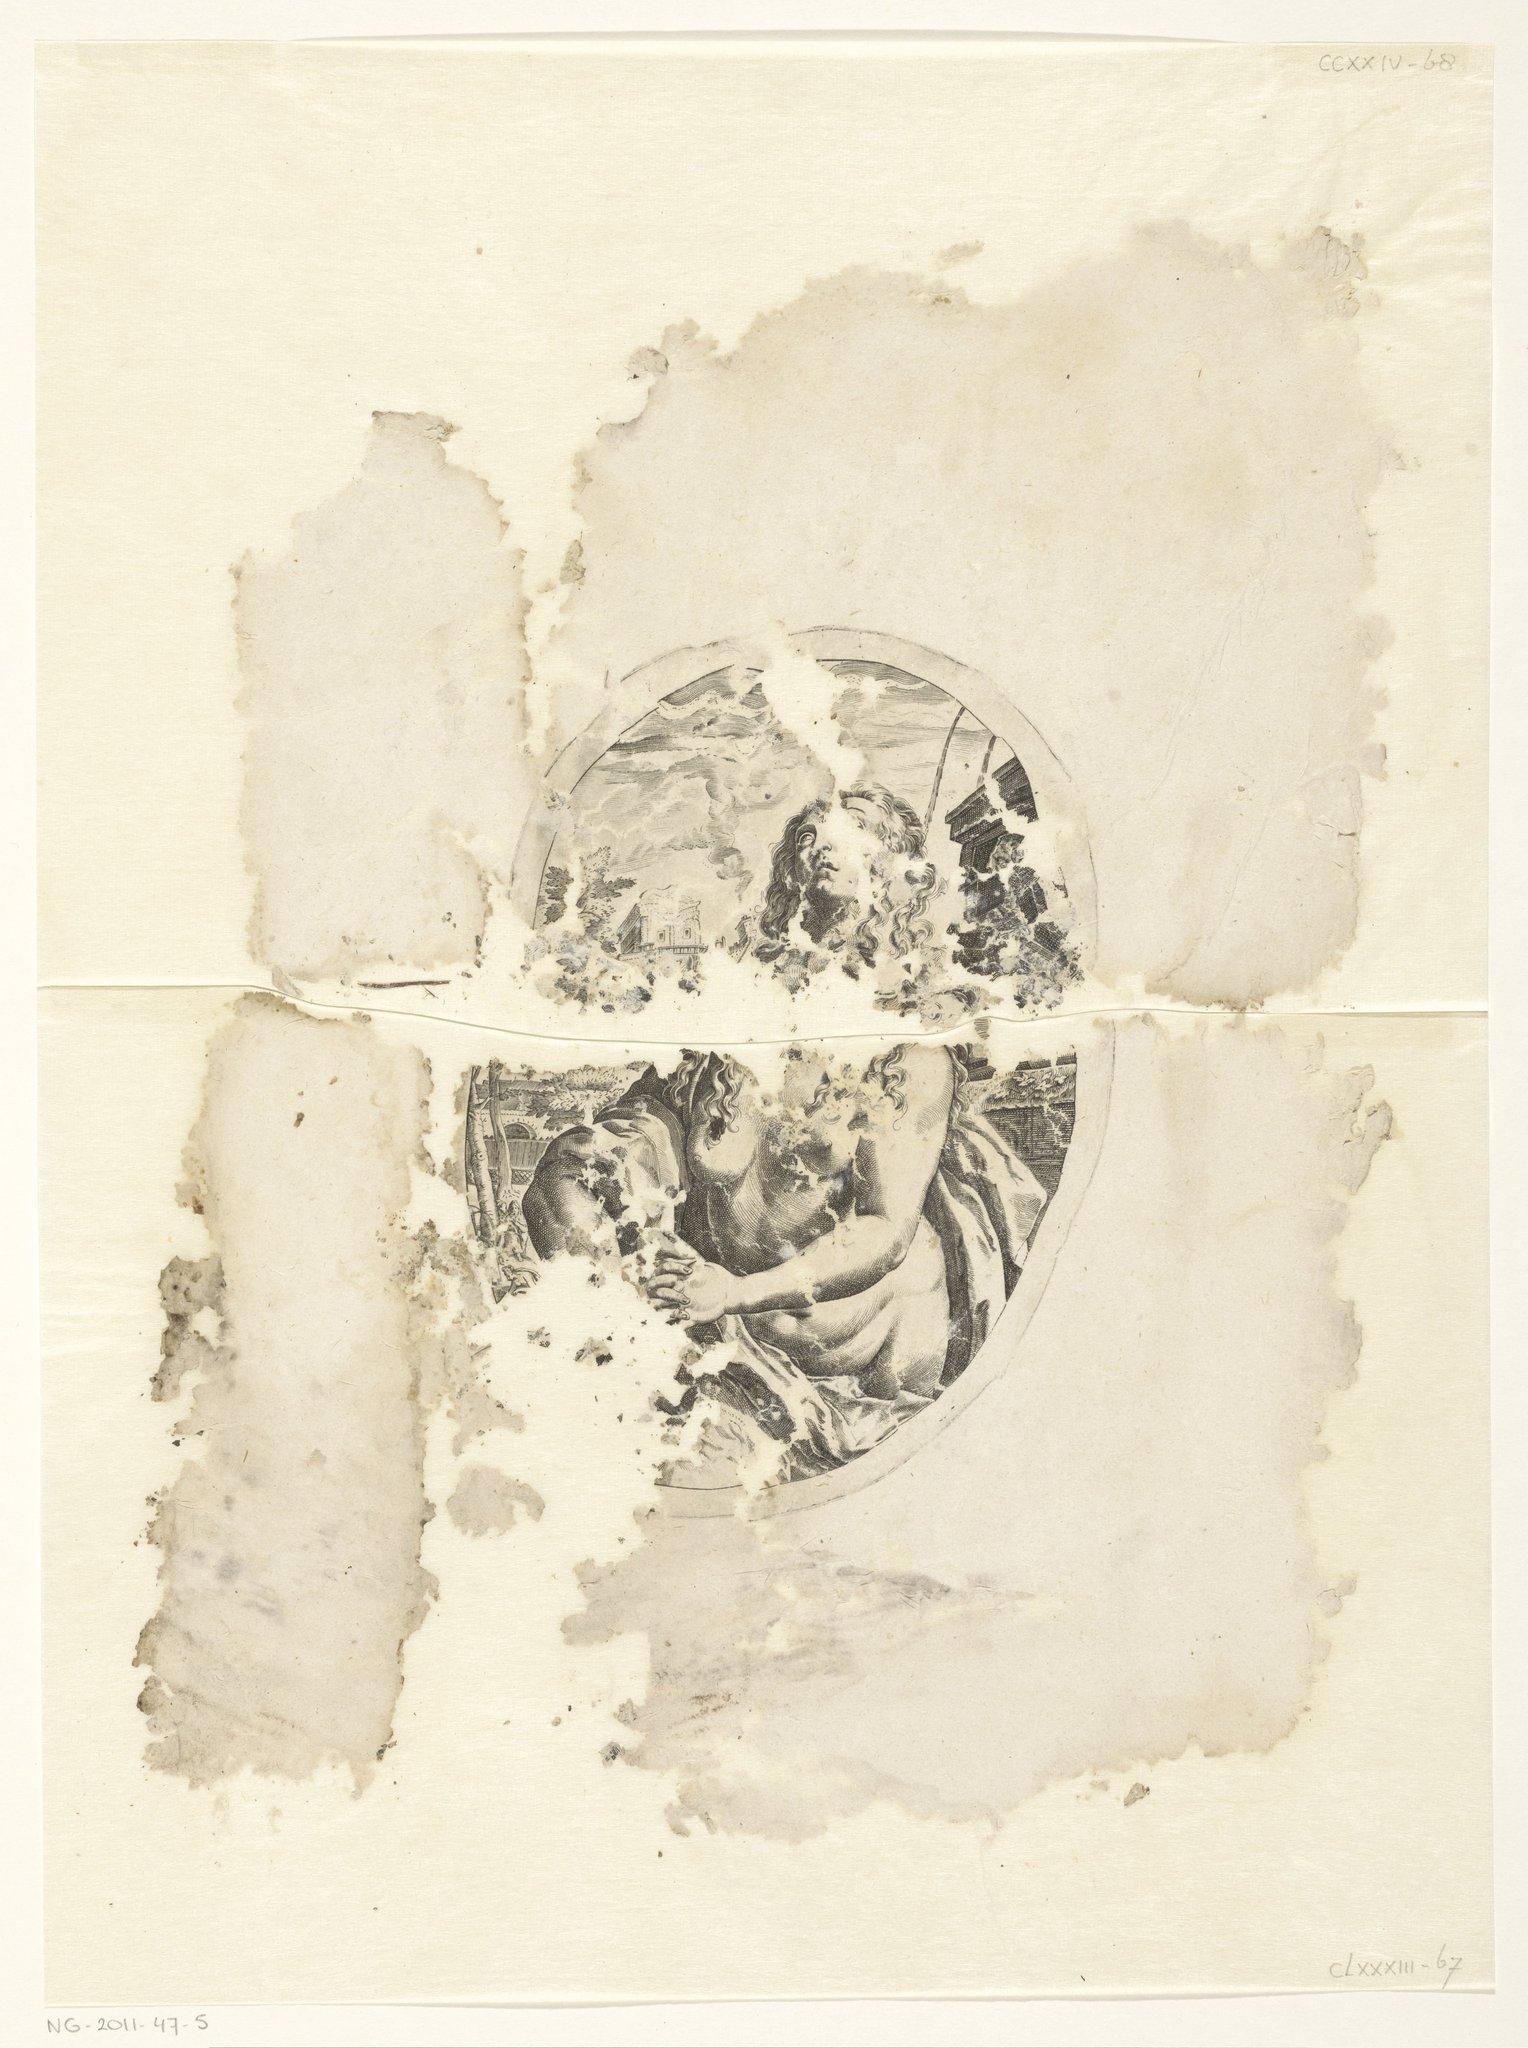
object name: print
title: Susanna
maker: Anonymous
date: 1583-1596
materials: paper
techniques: engraving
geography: northern netherlands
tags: the elders spying upon susanna, female persons from the old testament (with name) (not in biblical context)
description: De prenten in de Nova Zembla collectie zijn tijdens een expeditie van Willem Barendsz en Jacob van Heemskerk in 1596-1597 noodgedwongen in het winterkamp, het ‘Behouden Huis’, op het eiland achtergelaten. De prenten waren in één of meerdere stapels als handelswaar meegenomen vanuit Amsterdam. Bijna drie eeuwen later, in 1871, keerde de Noor Elling Carlsen terug naar Nova Zembla en vond daar de restanten van het ‘Behouden Huis, inclusief een groot deel van de inventaris. Een deel van de prenten, in de vorm van aaneengekoekte kluiten, werd toen ook teruggevonden. De papierkluiten waren soms op meerdere plekken gebroken. Tussen 1975-1979 zijn de prenten van elkaar gescheiden. Dit leverde in totaal ca. 1000 fragmenten van ca. 400 afdrukken van ca. 150 verschillende prenten op. Voor zover mogelijk zijn de fragmenten samengevoegd en zijn de prenten gereconstrueerd.